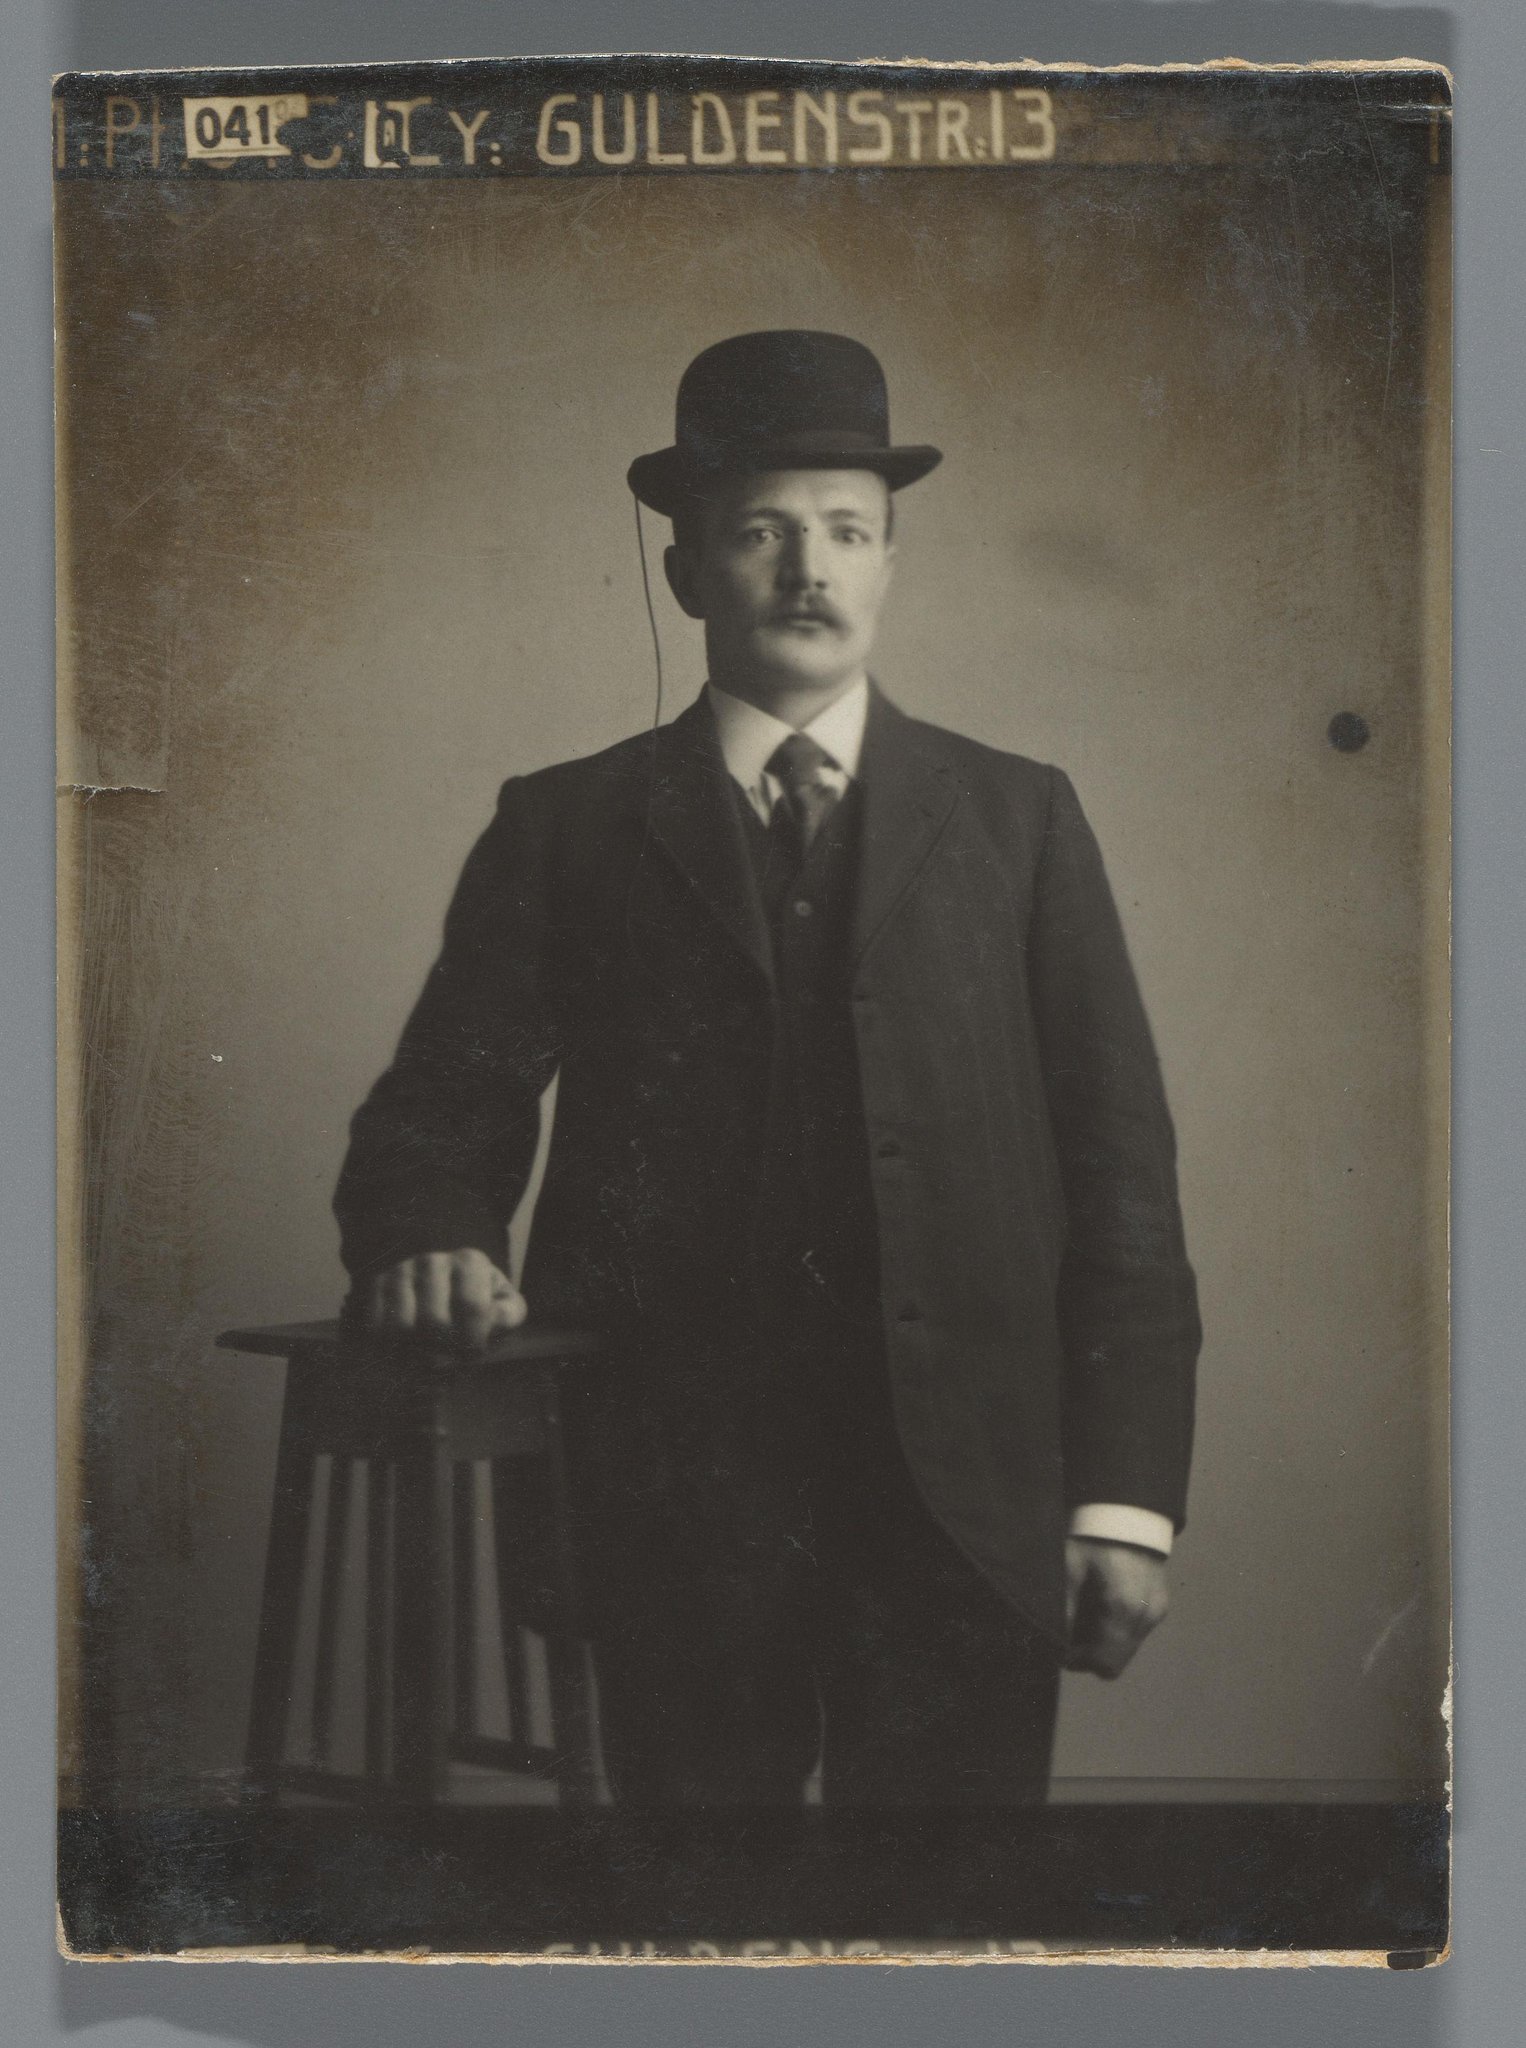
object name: snapshot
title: Portret van een man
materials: photographic support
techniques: gelatin silver print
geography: groningen